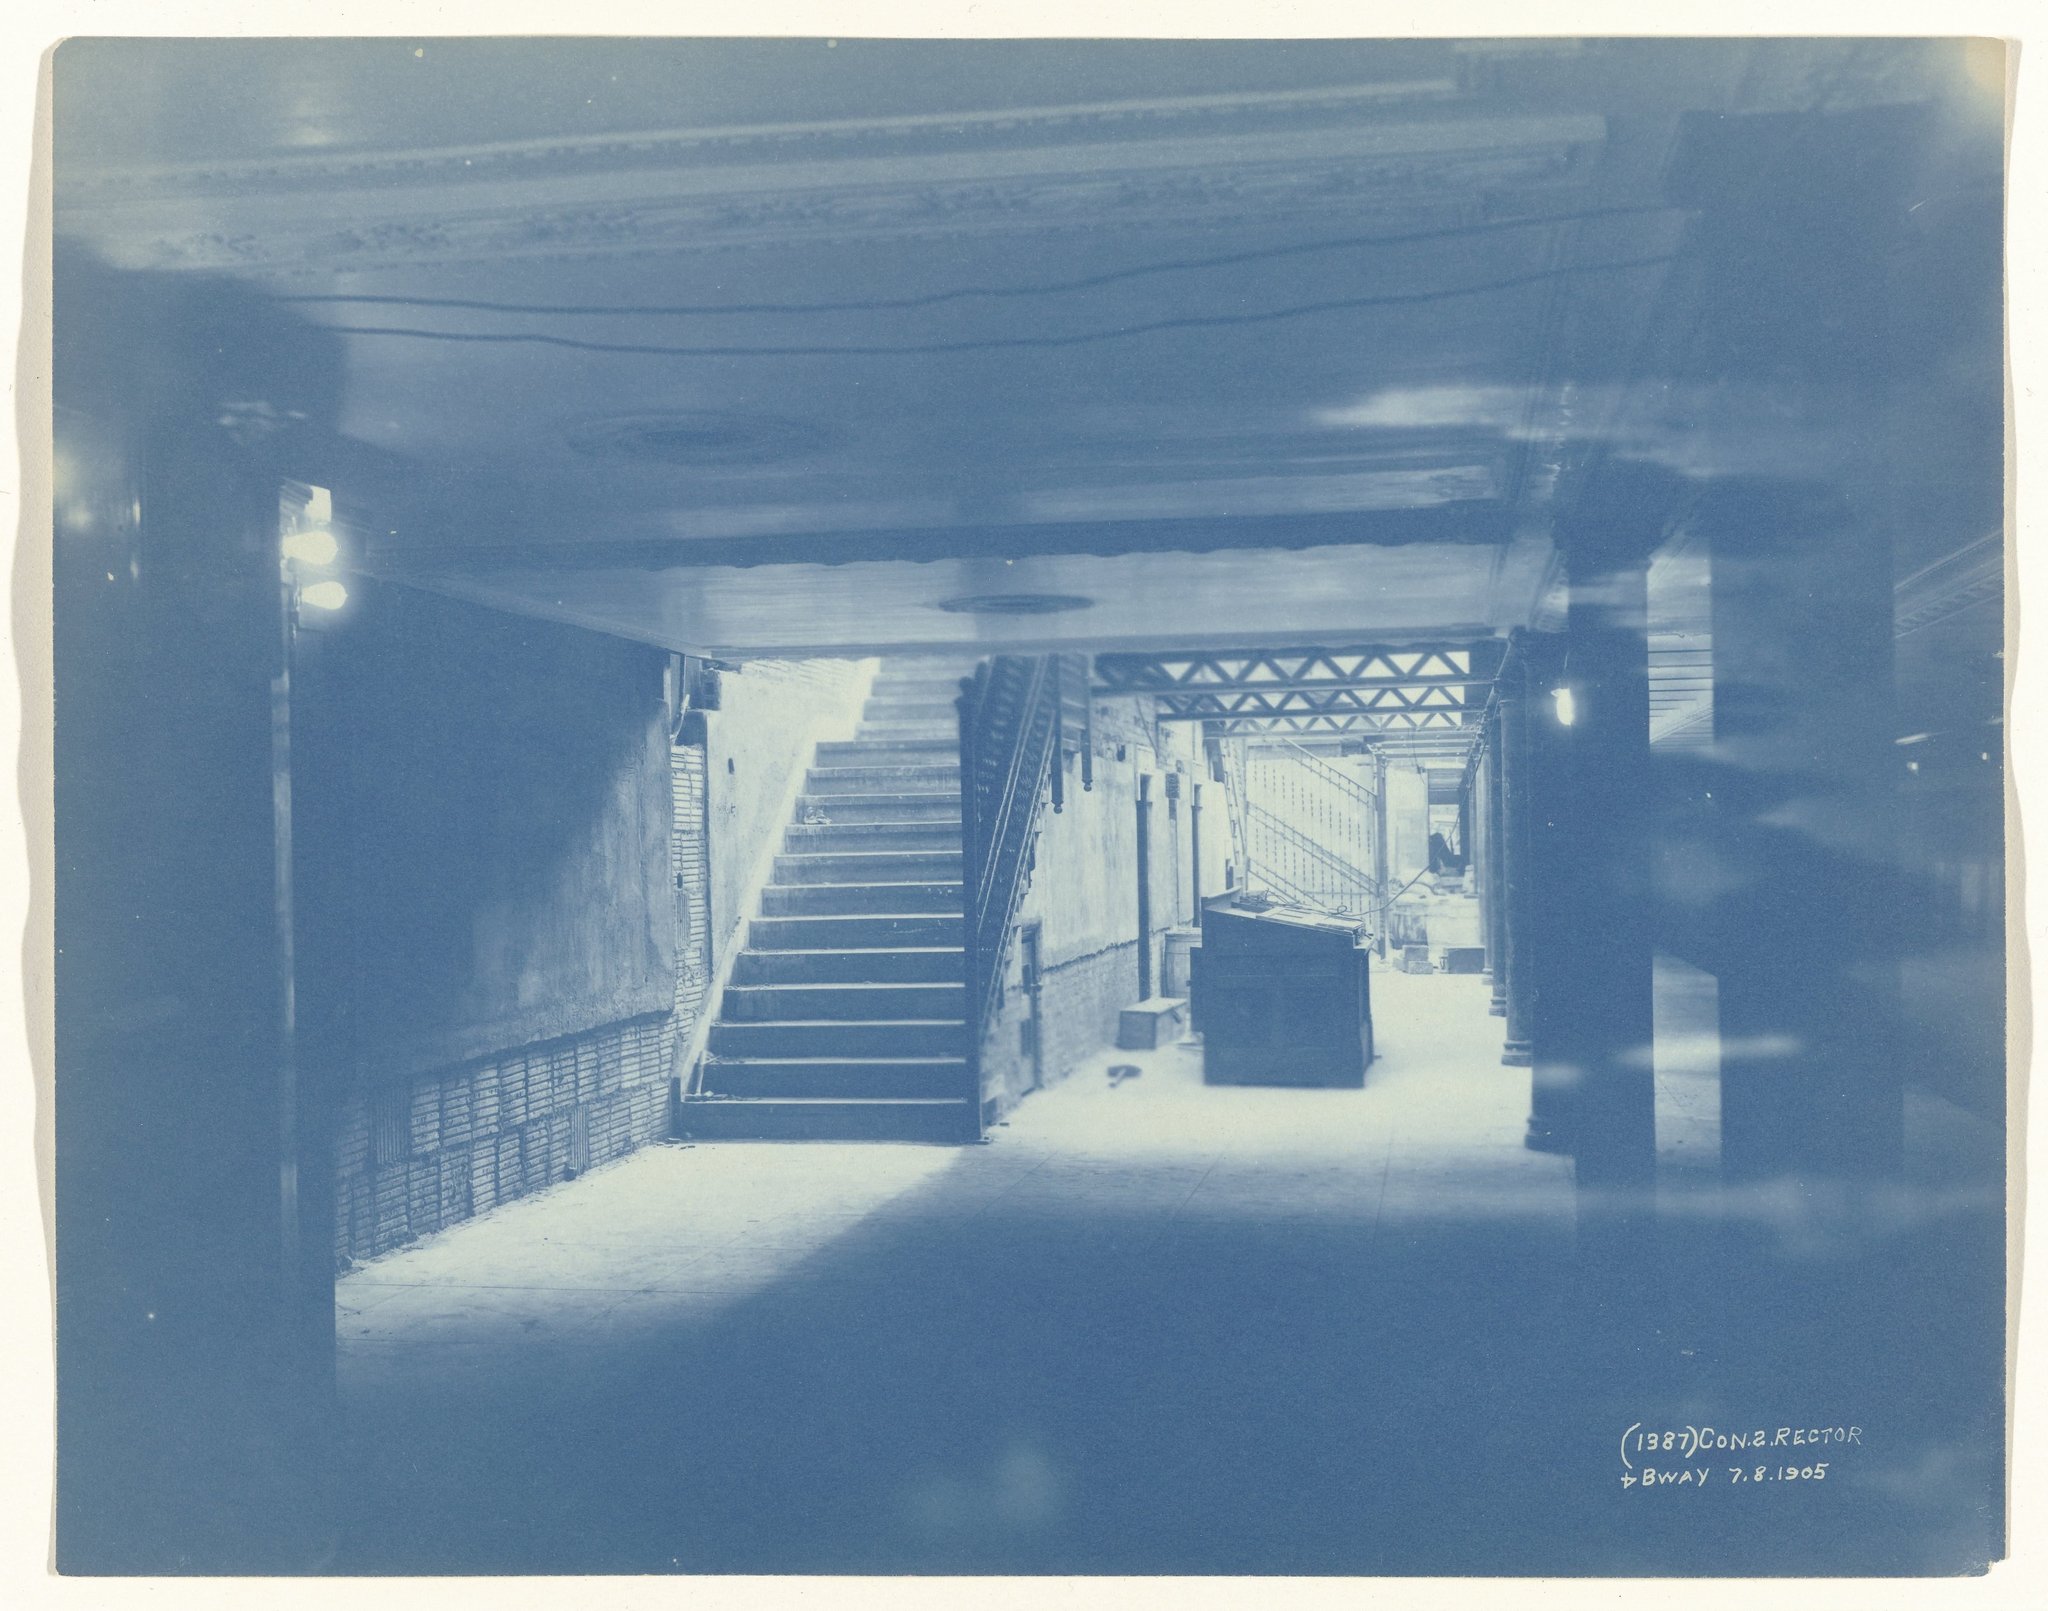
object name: photograph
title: Subway Rector Street, New York City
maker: Anonymous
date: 1905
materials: paper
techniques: cyanotype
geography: new york city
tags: underground station, new york (city)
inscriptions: stamp: ‘RAPID TRANSIT RAILROAD / COMMISSIONERS / RECEIVED / AUG 31 1905 / ENGINEER, FIRST DIVISION’, inscription: ‘(1387) CON.S.RECTOR / BWAY 7.8.1905’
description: Subway Rector Street/Broadway, New York City, NY, Verenigde Staten.